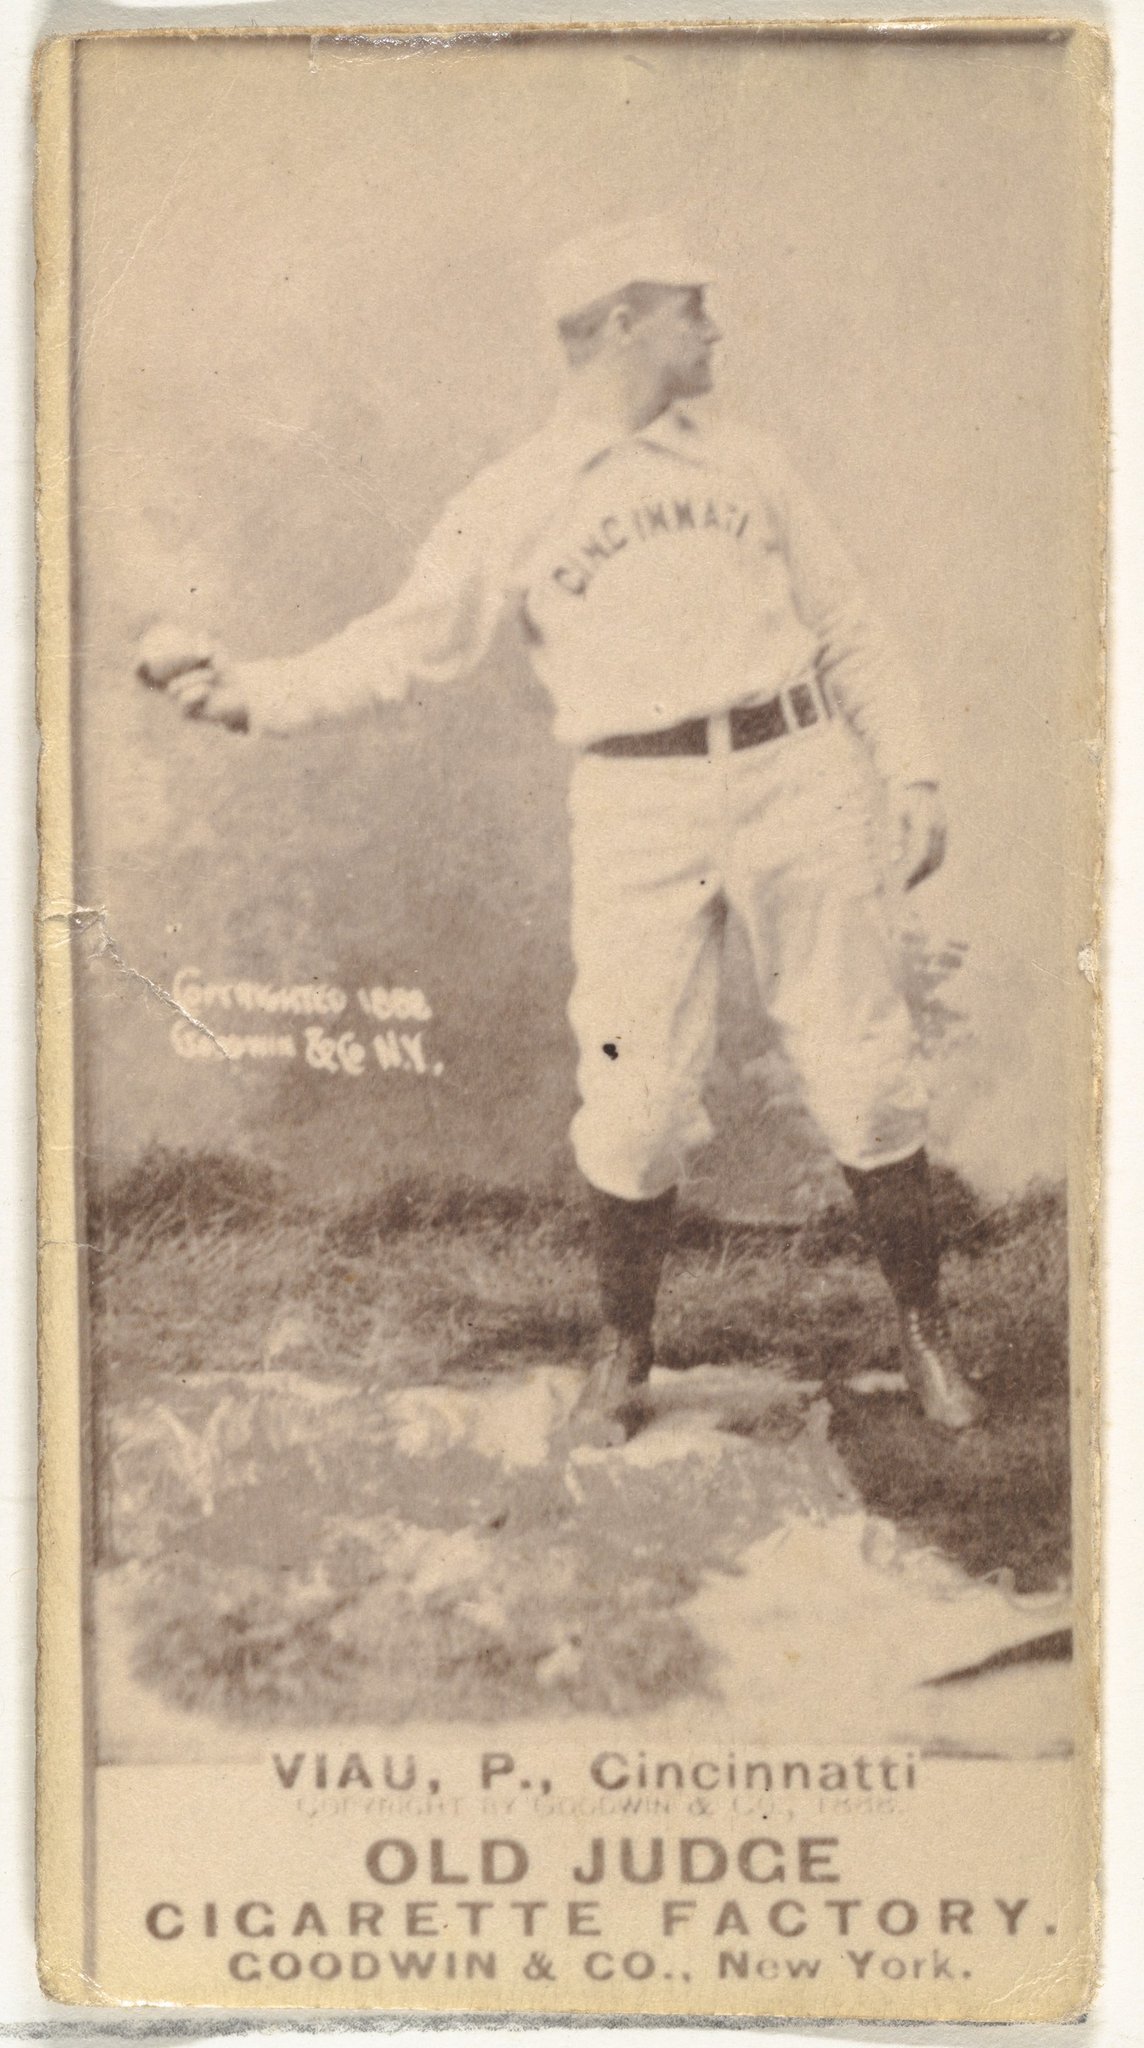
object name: baseball card, photograph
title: Leon A. "Lee" Viau, Pitcher, Cincinnati, from the Old Judge series (N172) for Old Judge Cigarettes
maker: goodwin & company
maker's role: publisher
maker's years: 1850-1950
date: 1888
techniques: albumen silver print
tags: men,portraits,baseball,athletes